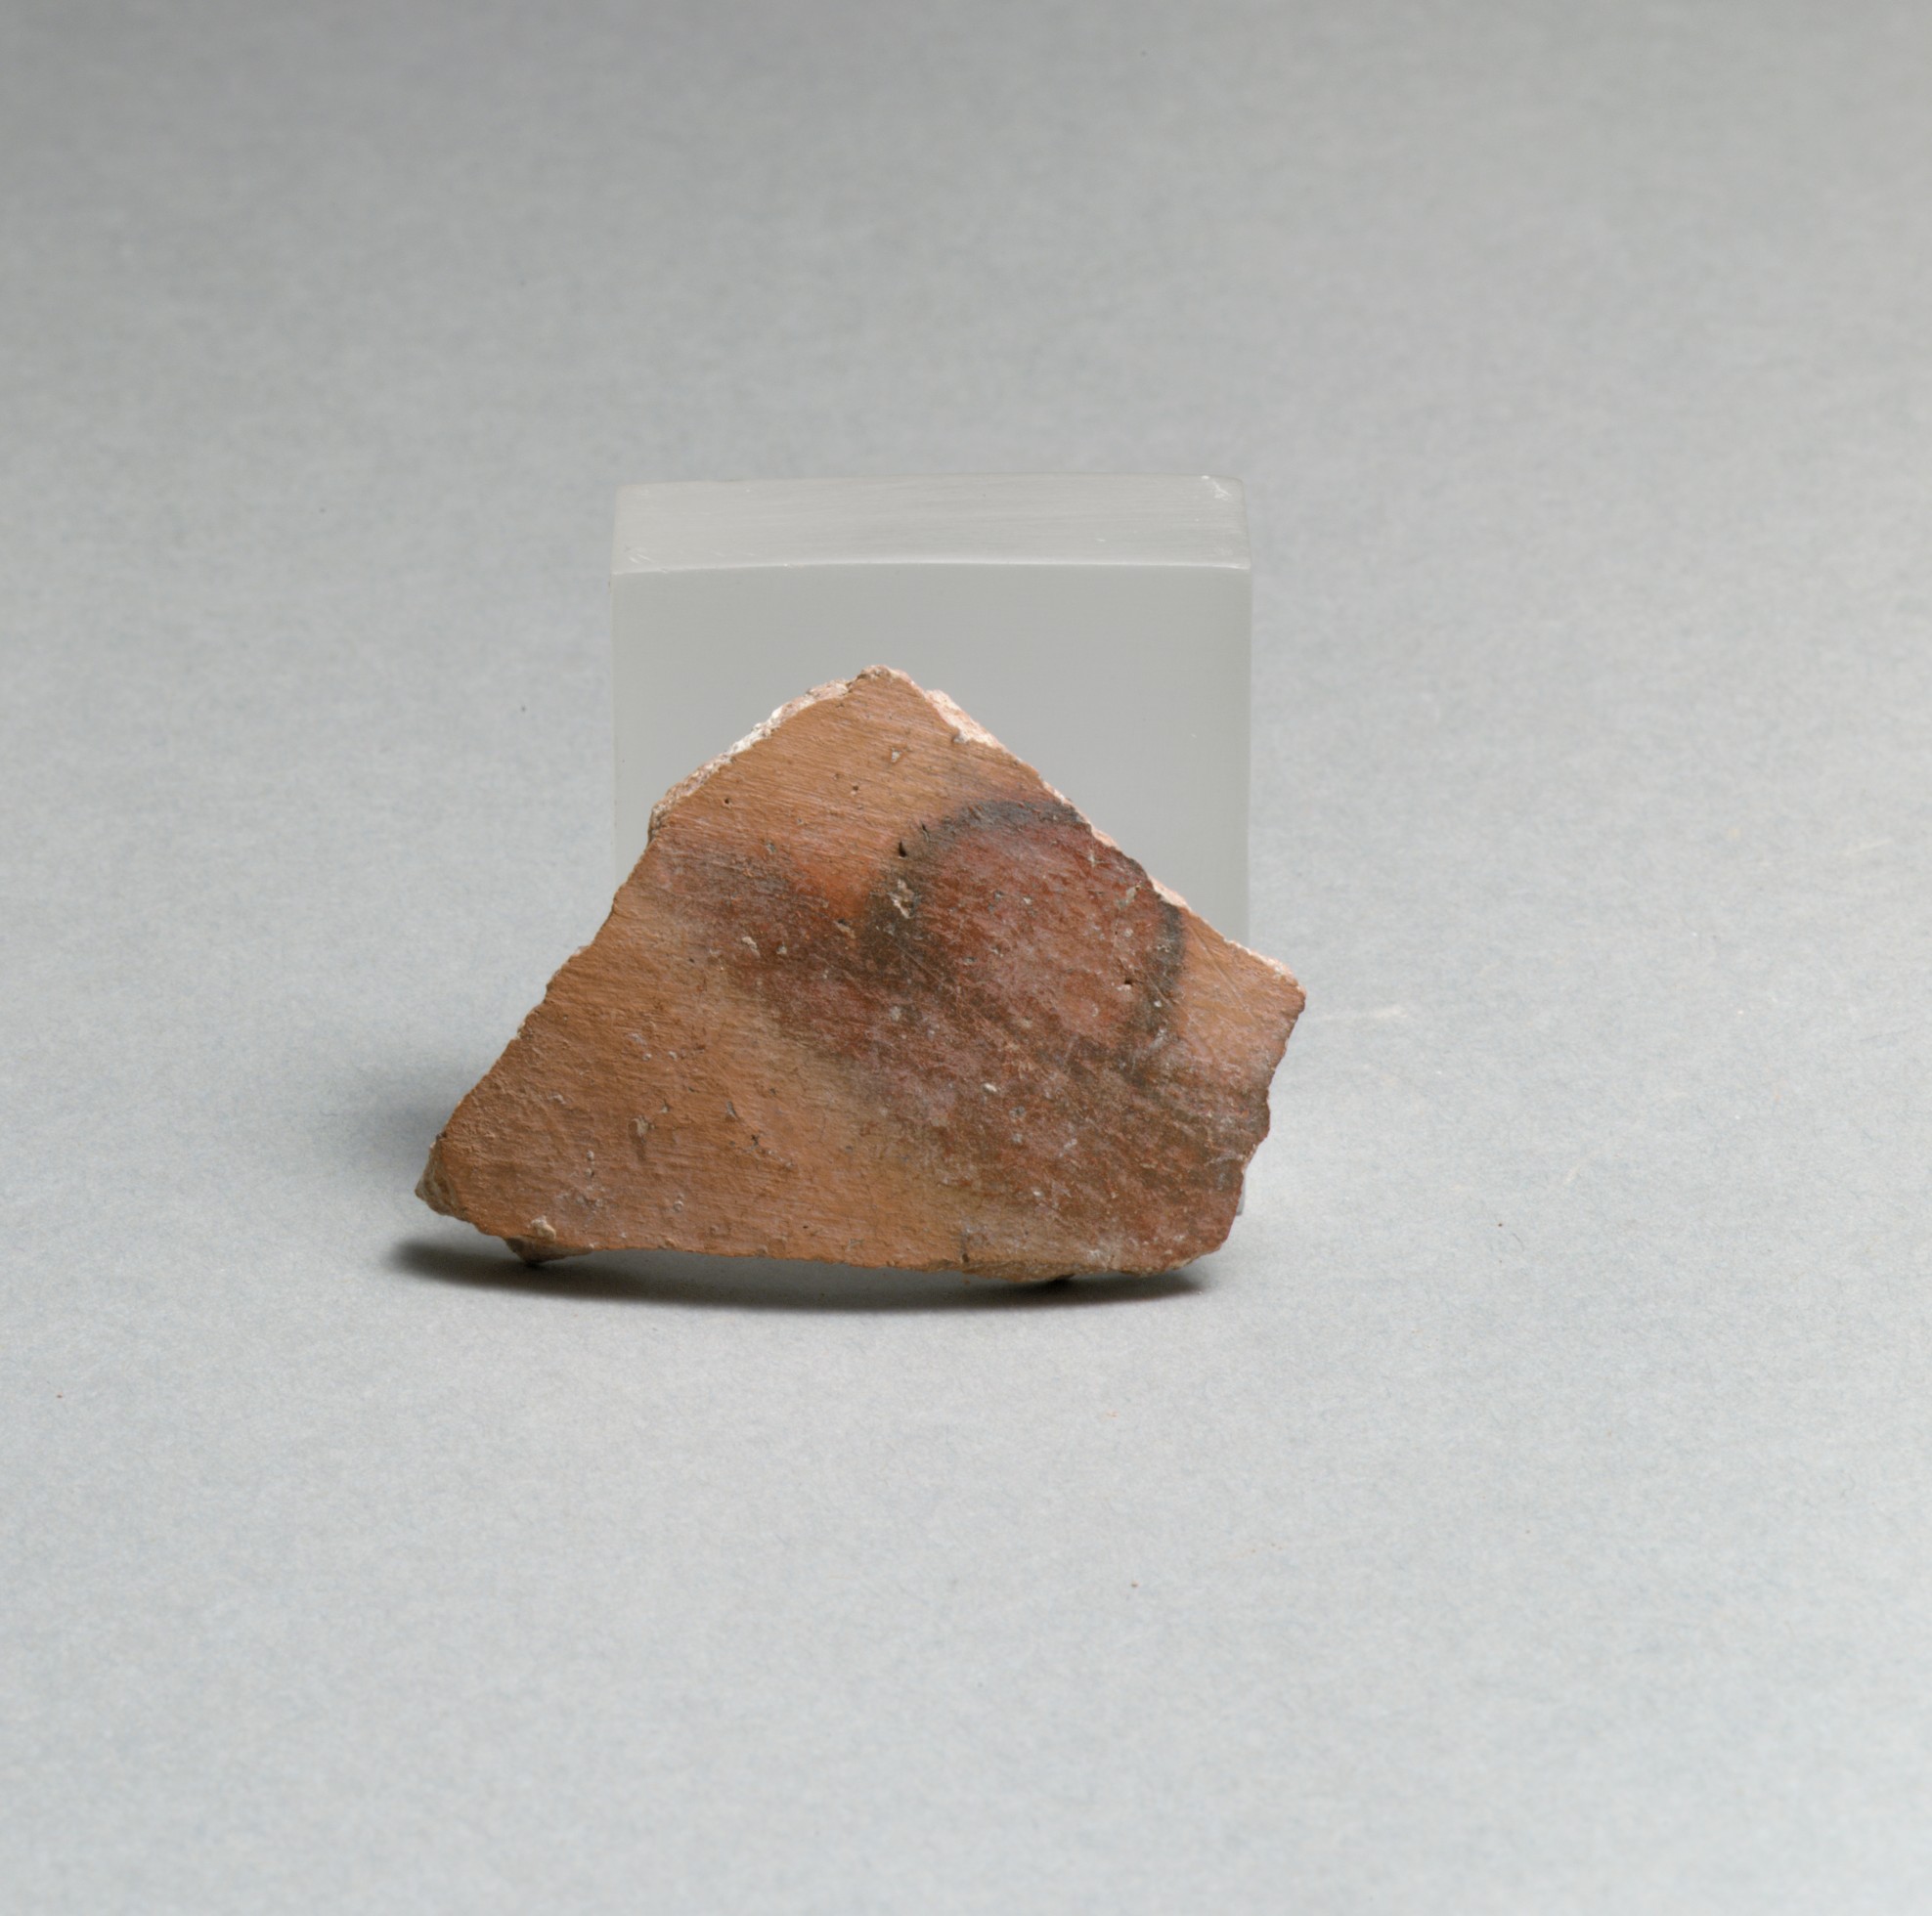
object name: vase fragment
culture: minoan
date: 2600-2000 BCE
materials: terracotta